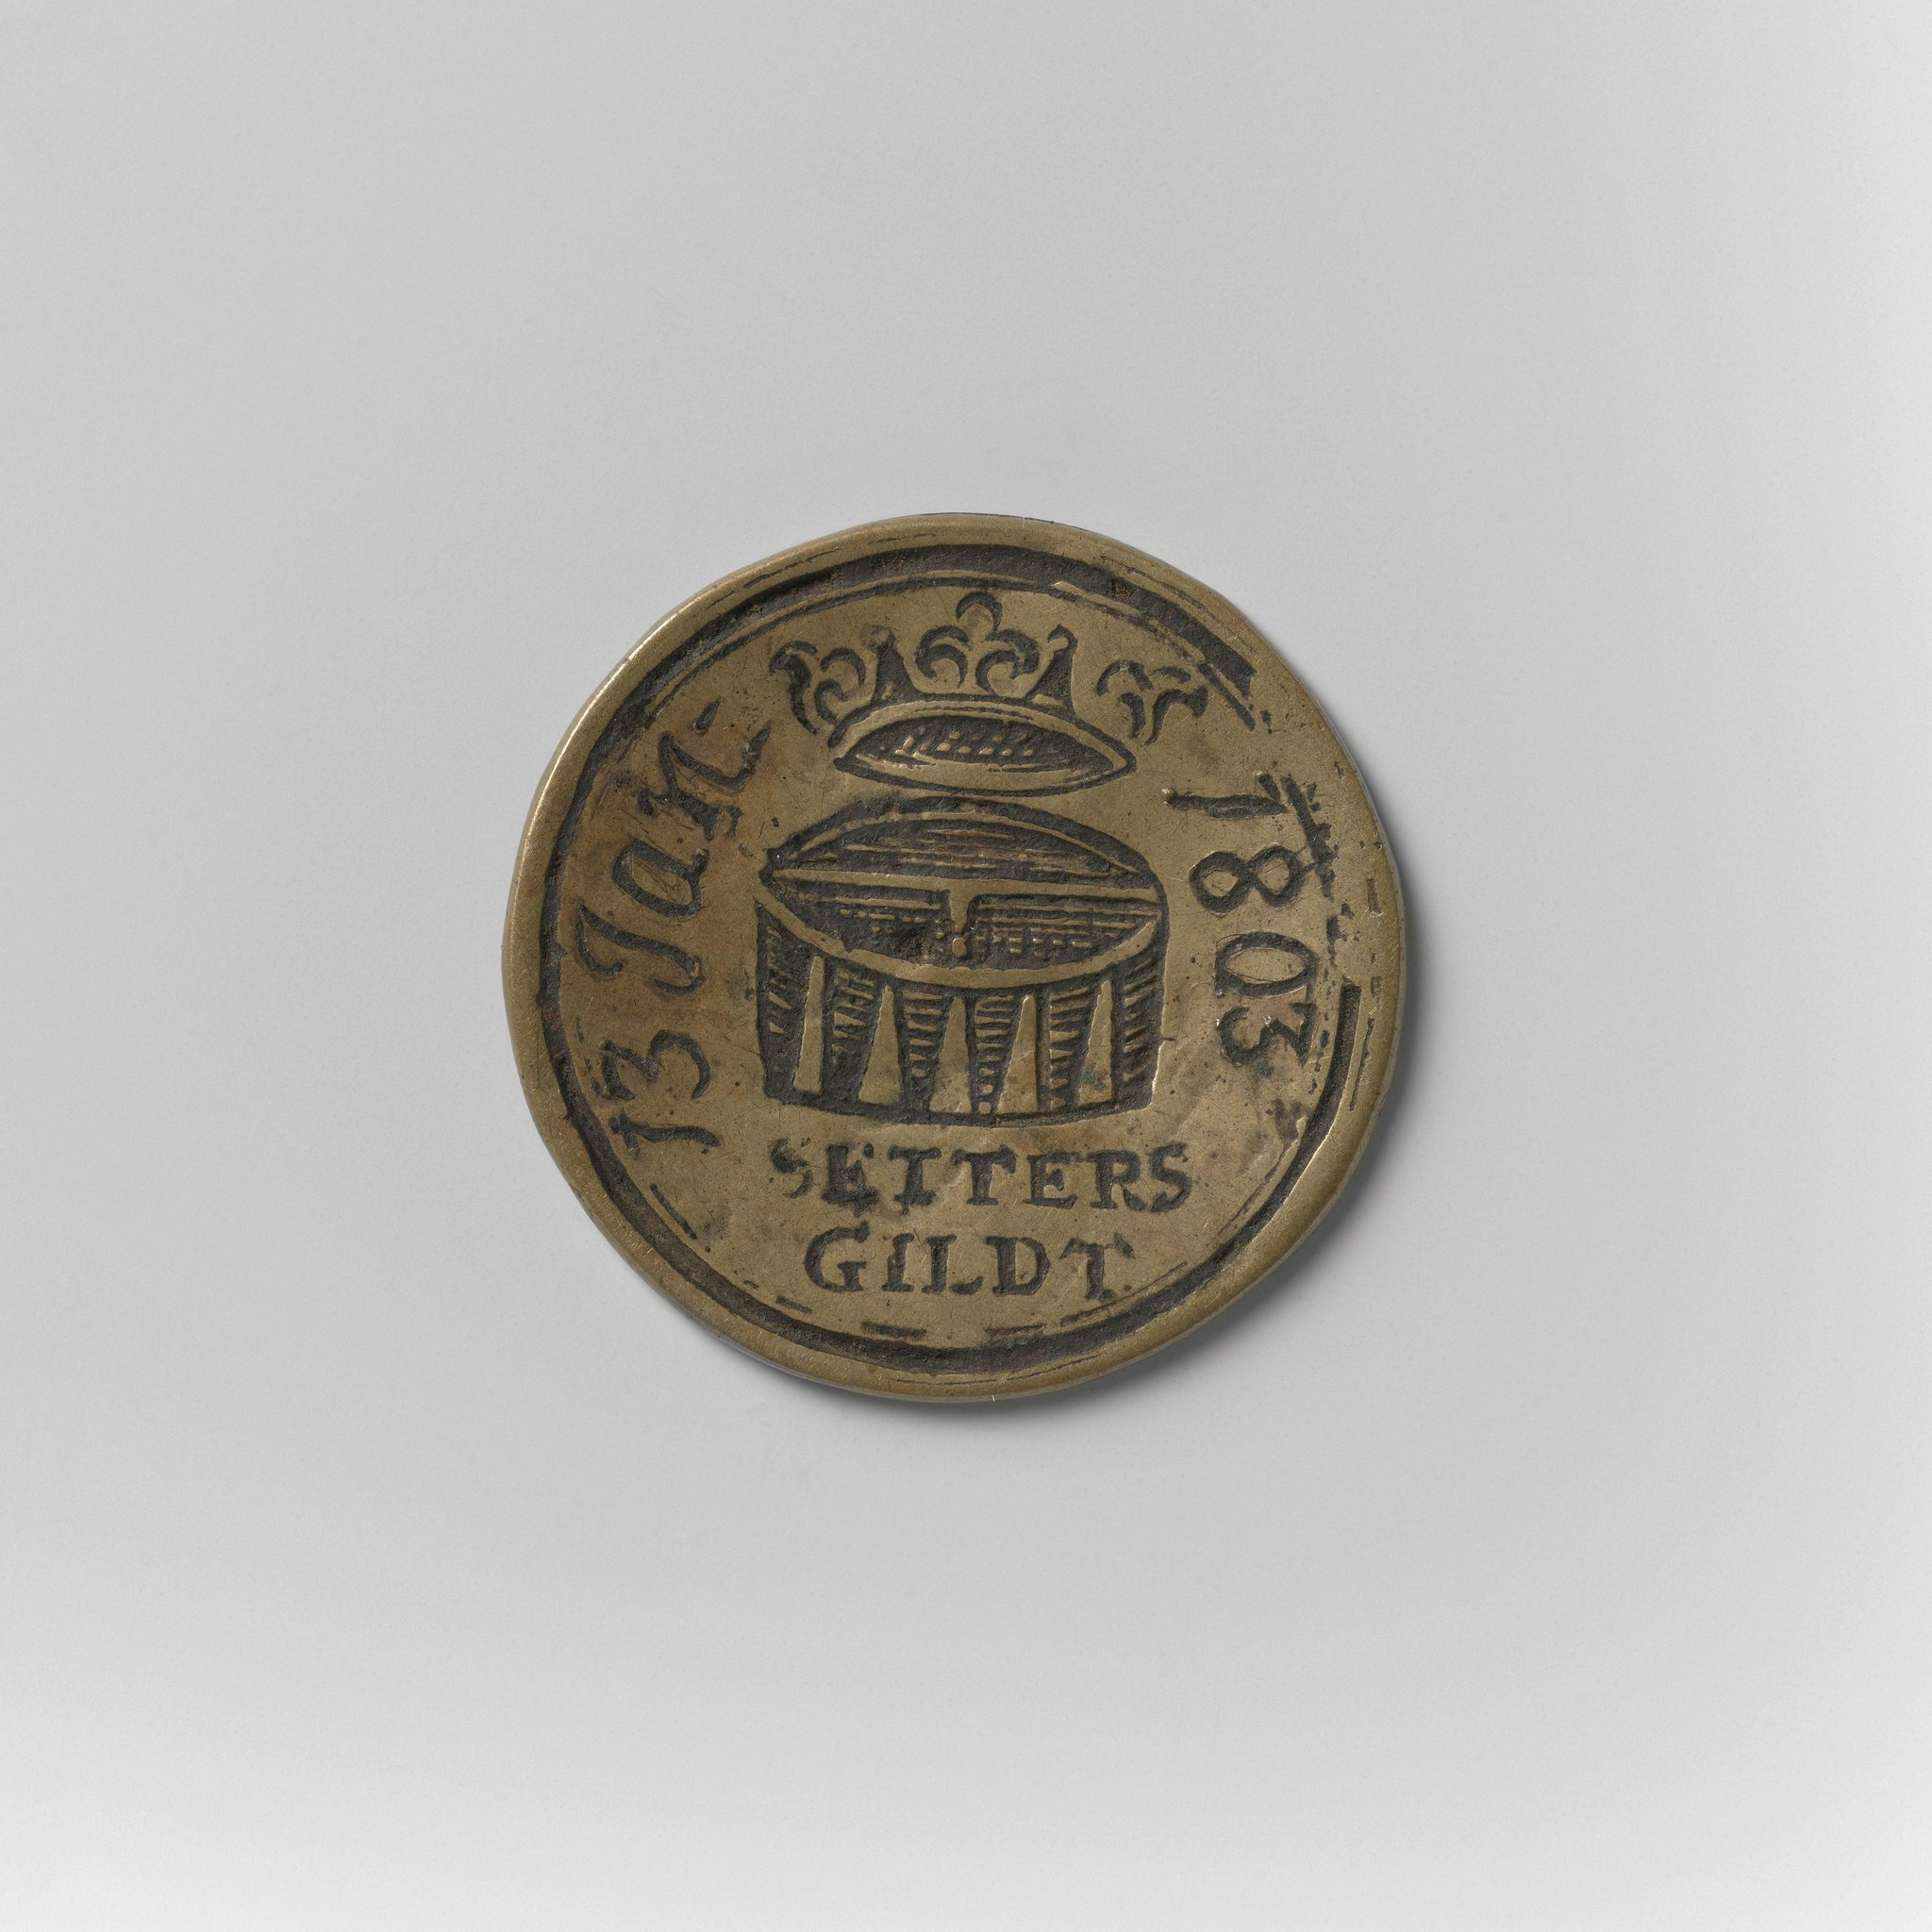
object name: medal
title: Presentiepenning van het Korenmeters- en Korenzettersgilde te Amsterdam, 1803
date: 1803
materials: brass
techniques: engraving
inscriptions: inscription, inscription: ‘13 Jan - 1803’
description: Ronde plaat messing gegraveerd op de voorzijde een gekroonde korenmaat bover de tekst SETTERS GILDT, met datuminscriptie rondom, op de keerzijde vijf regels tekst, op naam van C. Zwaardveeger 13 januari 1803